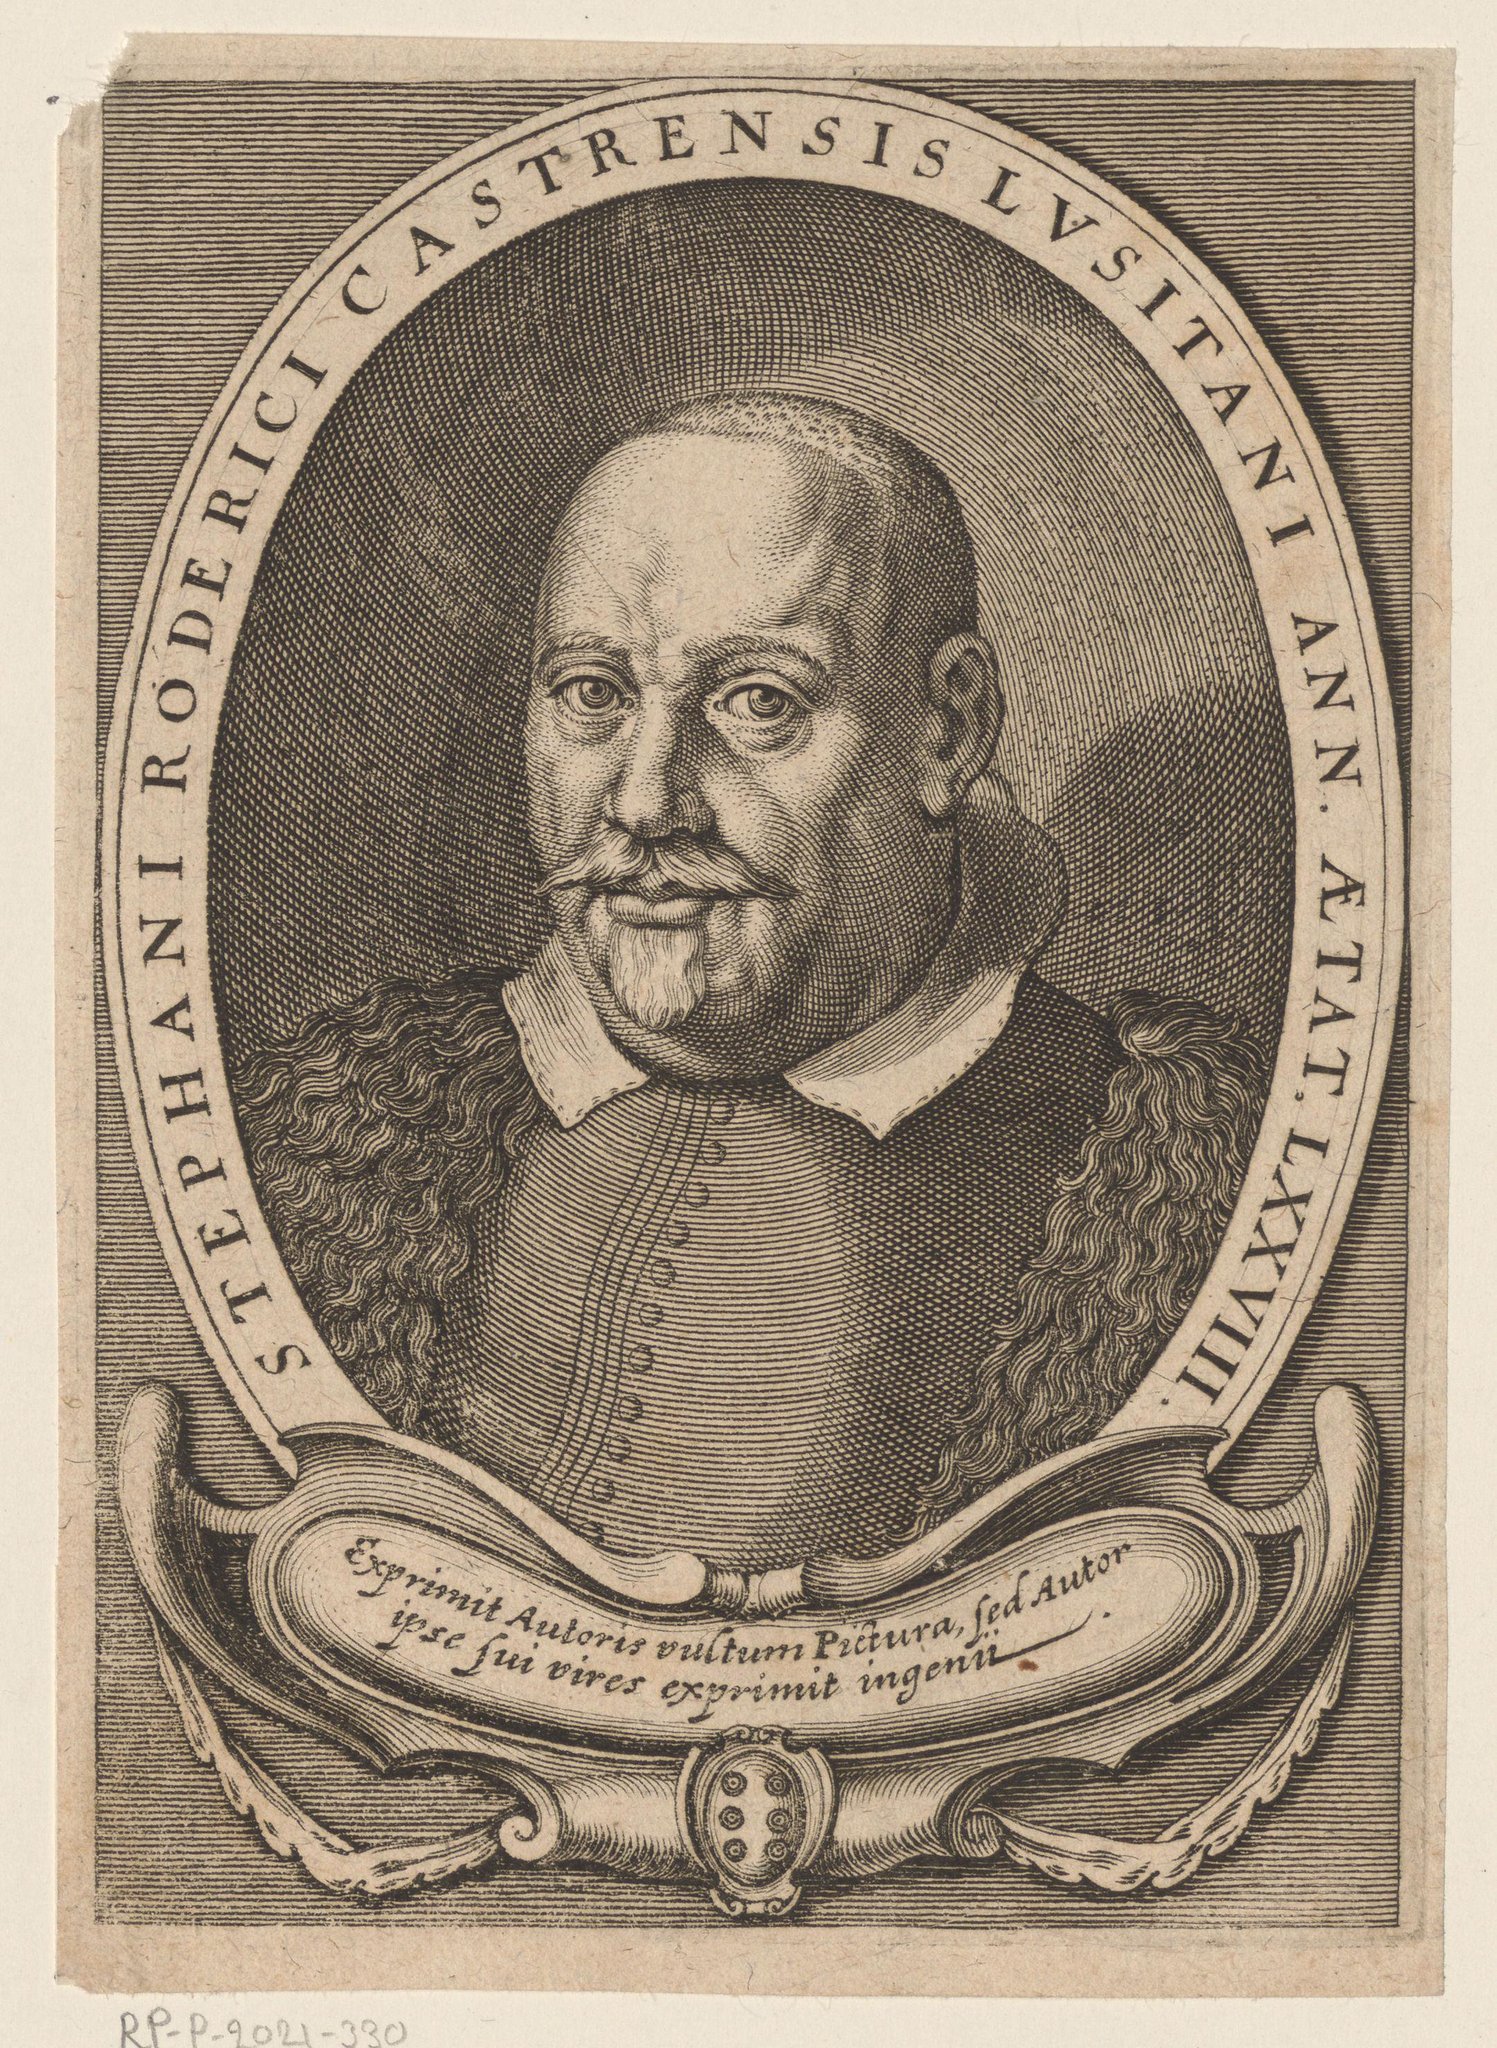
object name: print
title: Portret van Estêvão Rodrigues de Castro op 78-jarige leeftijd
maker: Anonymous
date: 1668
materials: paper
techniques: engraving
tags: historical persons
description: Prent mogelijk uit: Castro, Estêvão Rodrigues de. Tractatus de natura mulierbri seu disputationes (...). Frankfurt am Main: Hermann von Sand, 1668.